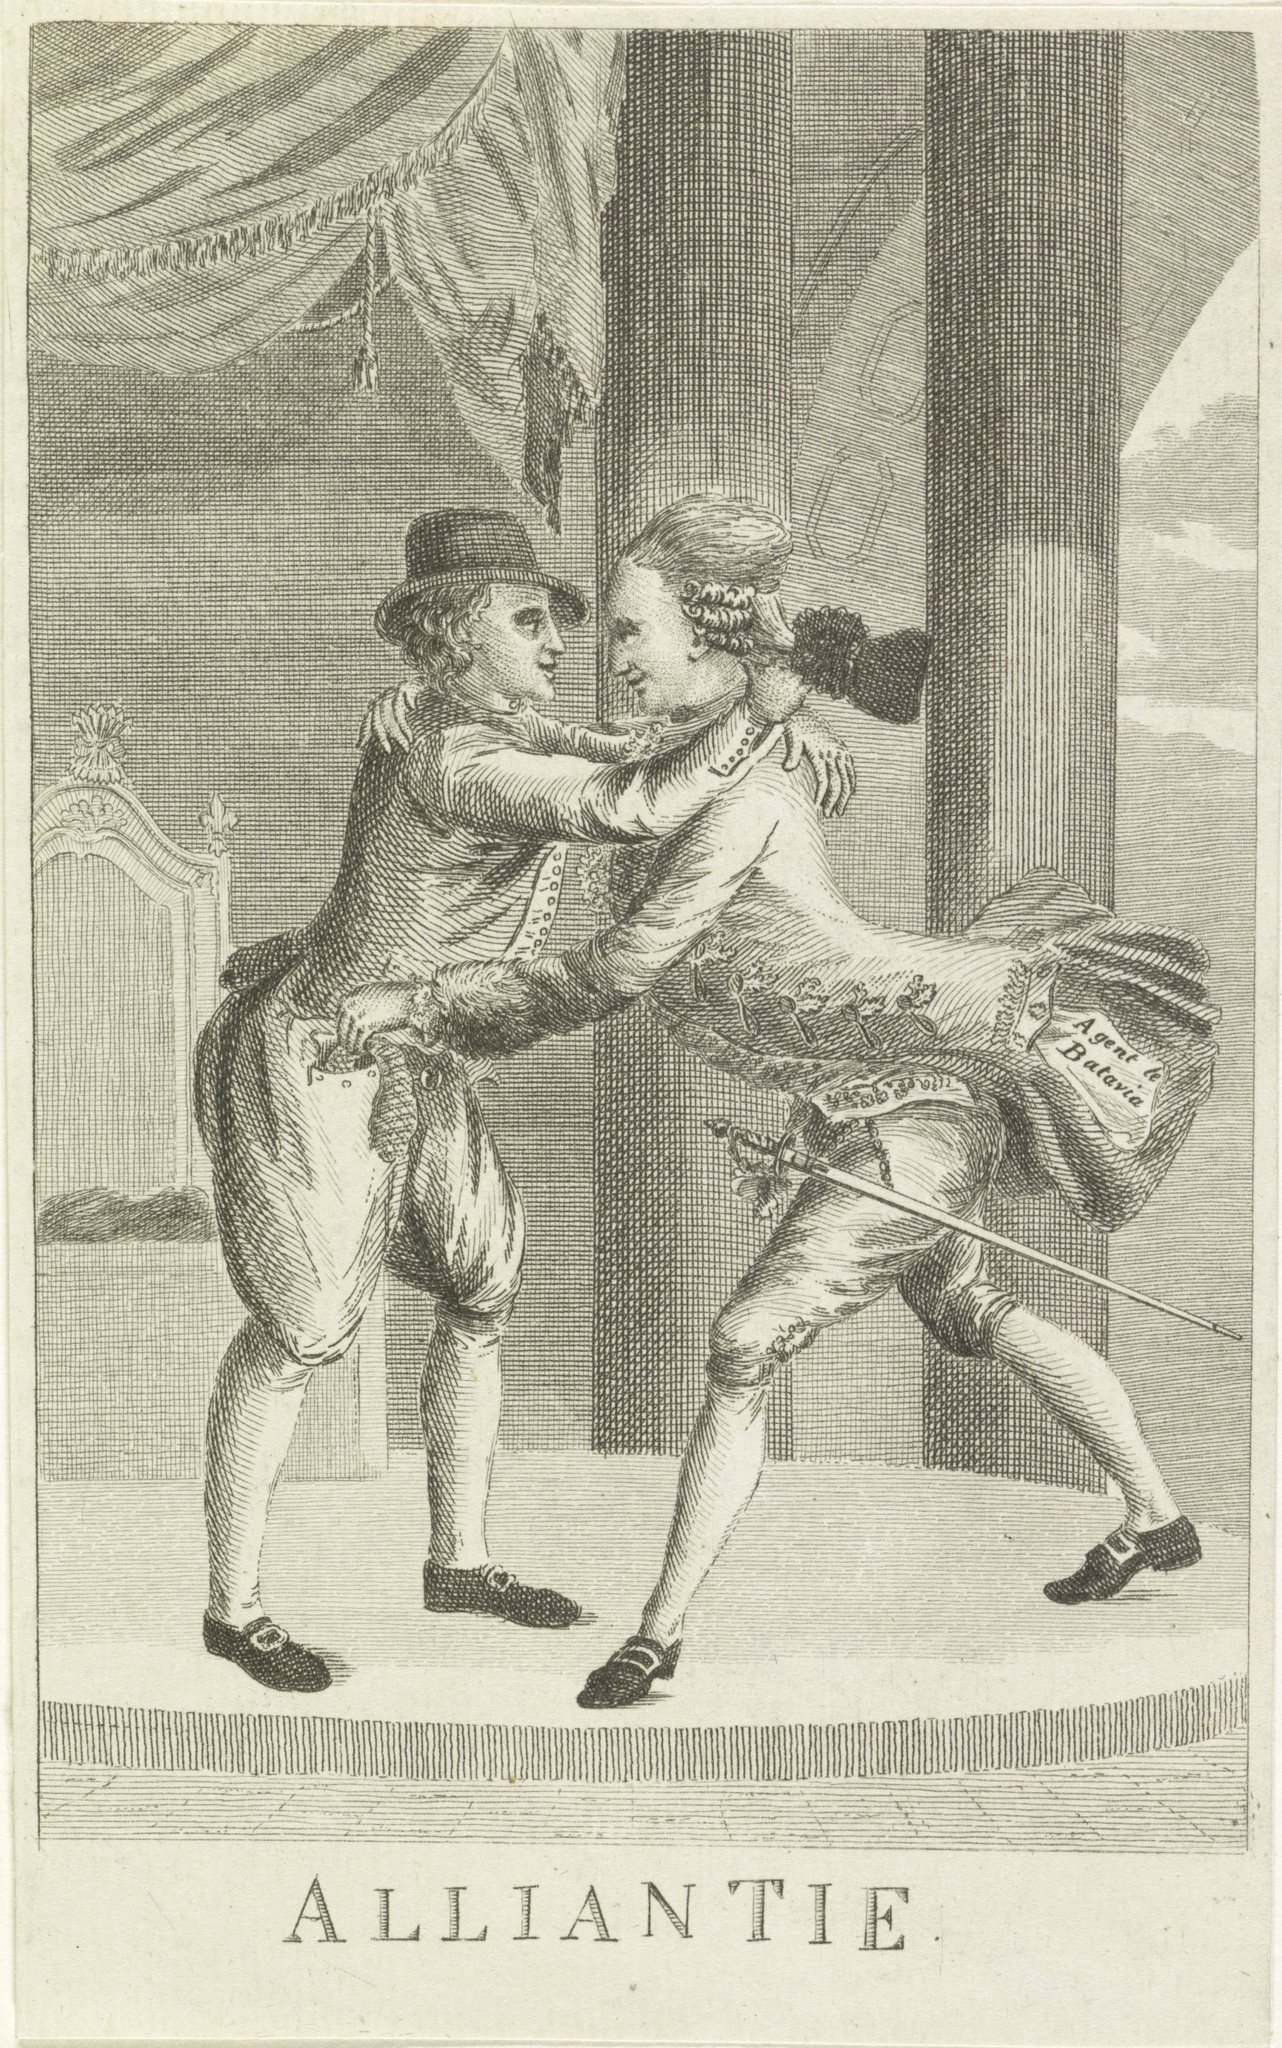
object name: print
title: Spotprent op de Franse broederschap, 1785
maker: Anonymous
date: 1785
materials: paper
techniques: engraving, etching, letterpress printing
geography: netherlands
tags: brotherly love, pickpocket, alliance with france (1785)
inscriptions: collector's mark: Lugt 2228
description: Spotprent op de Franse broederschap, 1785. Een Fransman en Hollander omarmen elkaar terwijl de Fransman de beurs van de Hollander steelt. Waarschijnlijk naar aanleiding van de eerste Alliantie met de Franse Republiek in 1785.